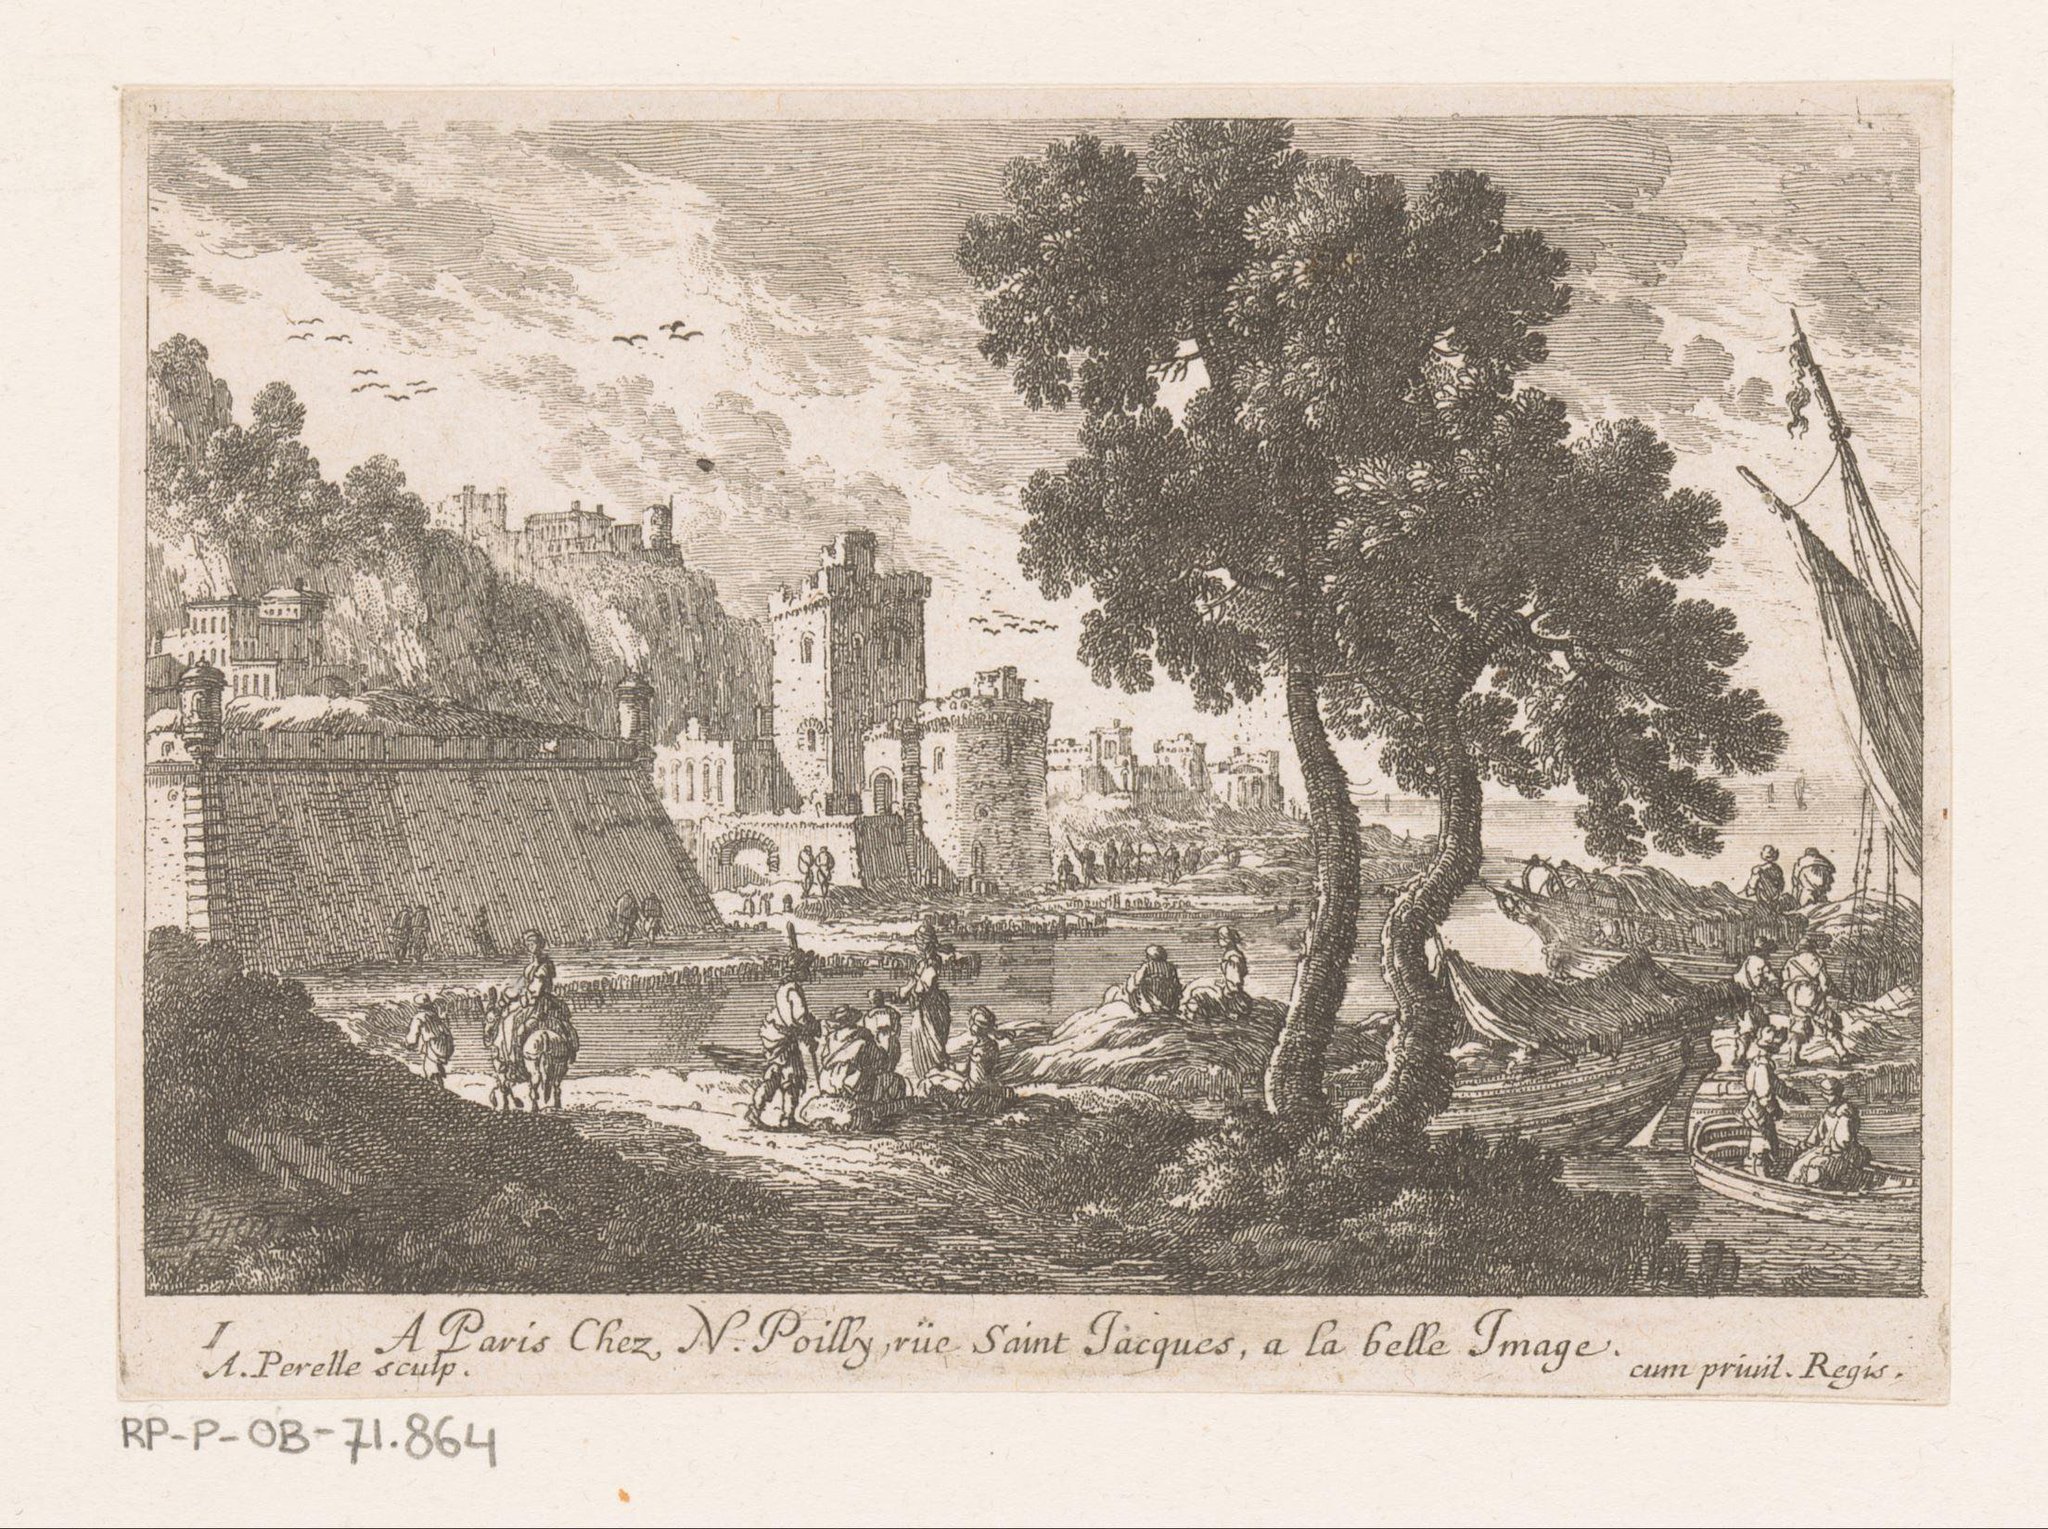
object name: print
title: Havengezicht met twee bomen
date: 1650-1695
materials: paper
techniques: etching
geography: paris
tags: coast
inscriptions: collector's mark: Lugt 240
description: Prenten met het signatuur 'Perelle' kunnen zowel door vader Gabriel als door zonen Nicolas en Adam gemaakt zijn.